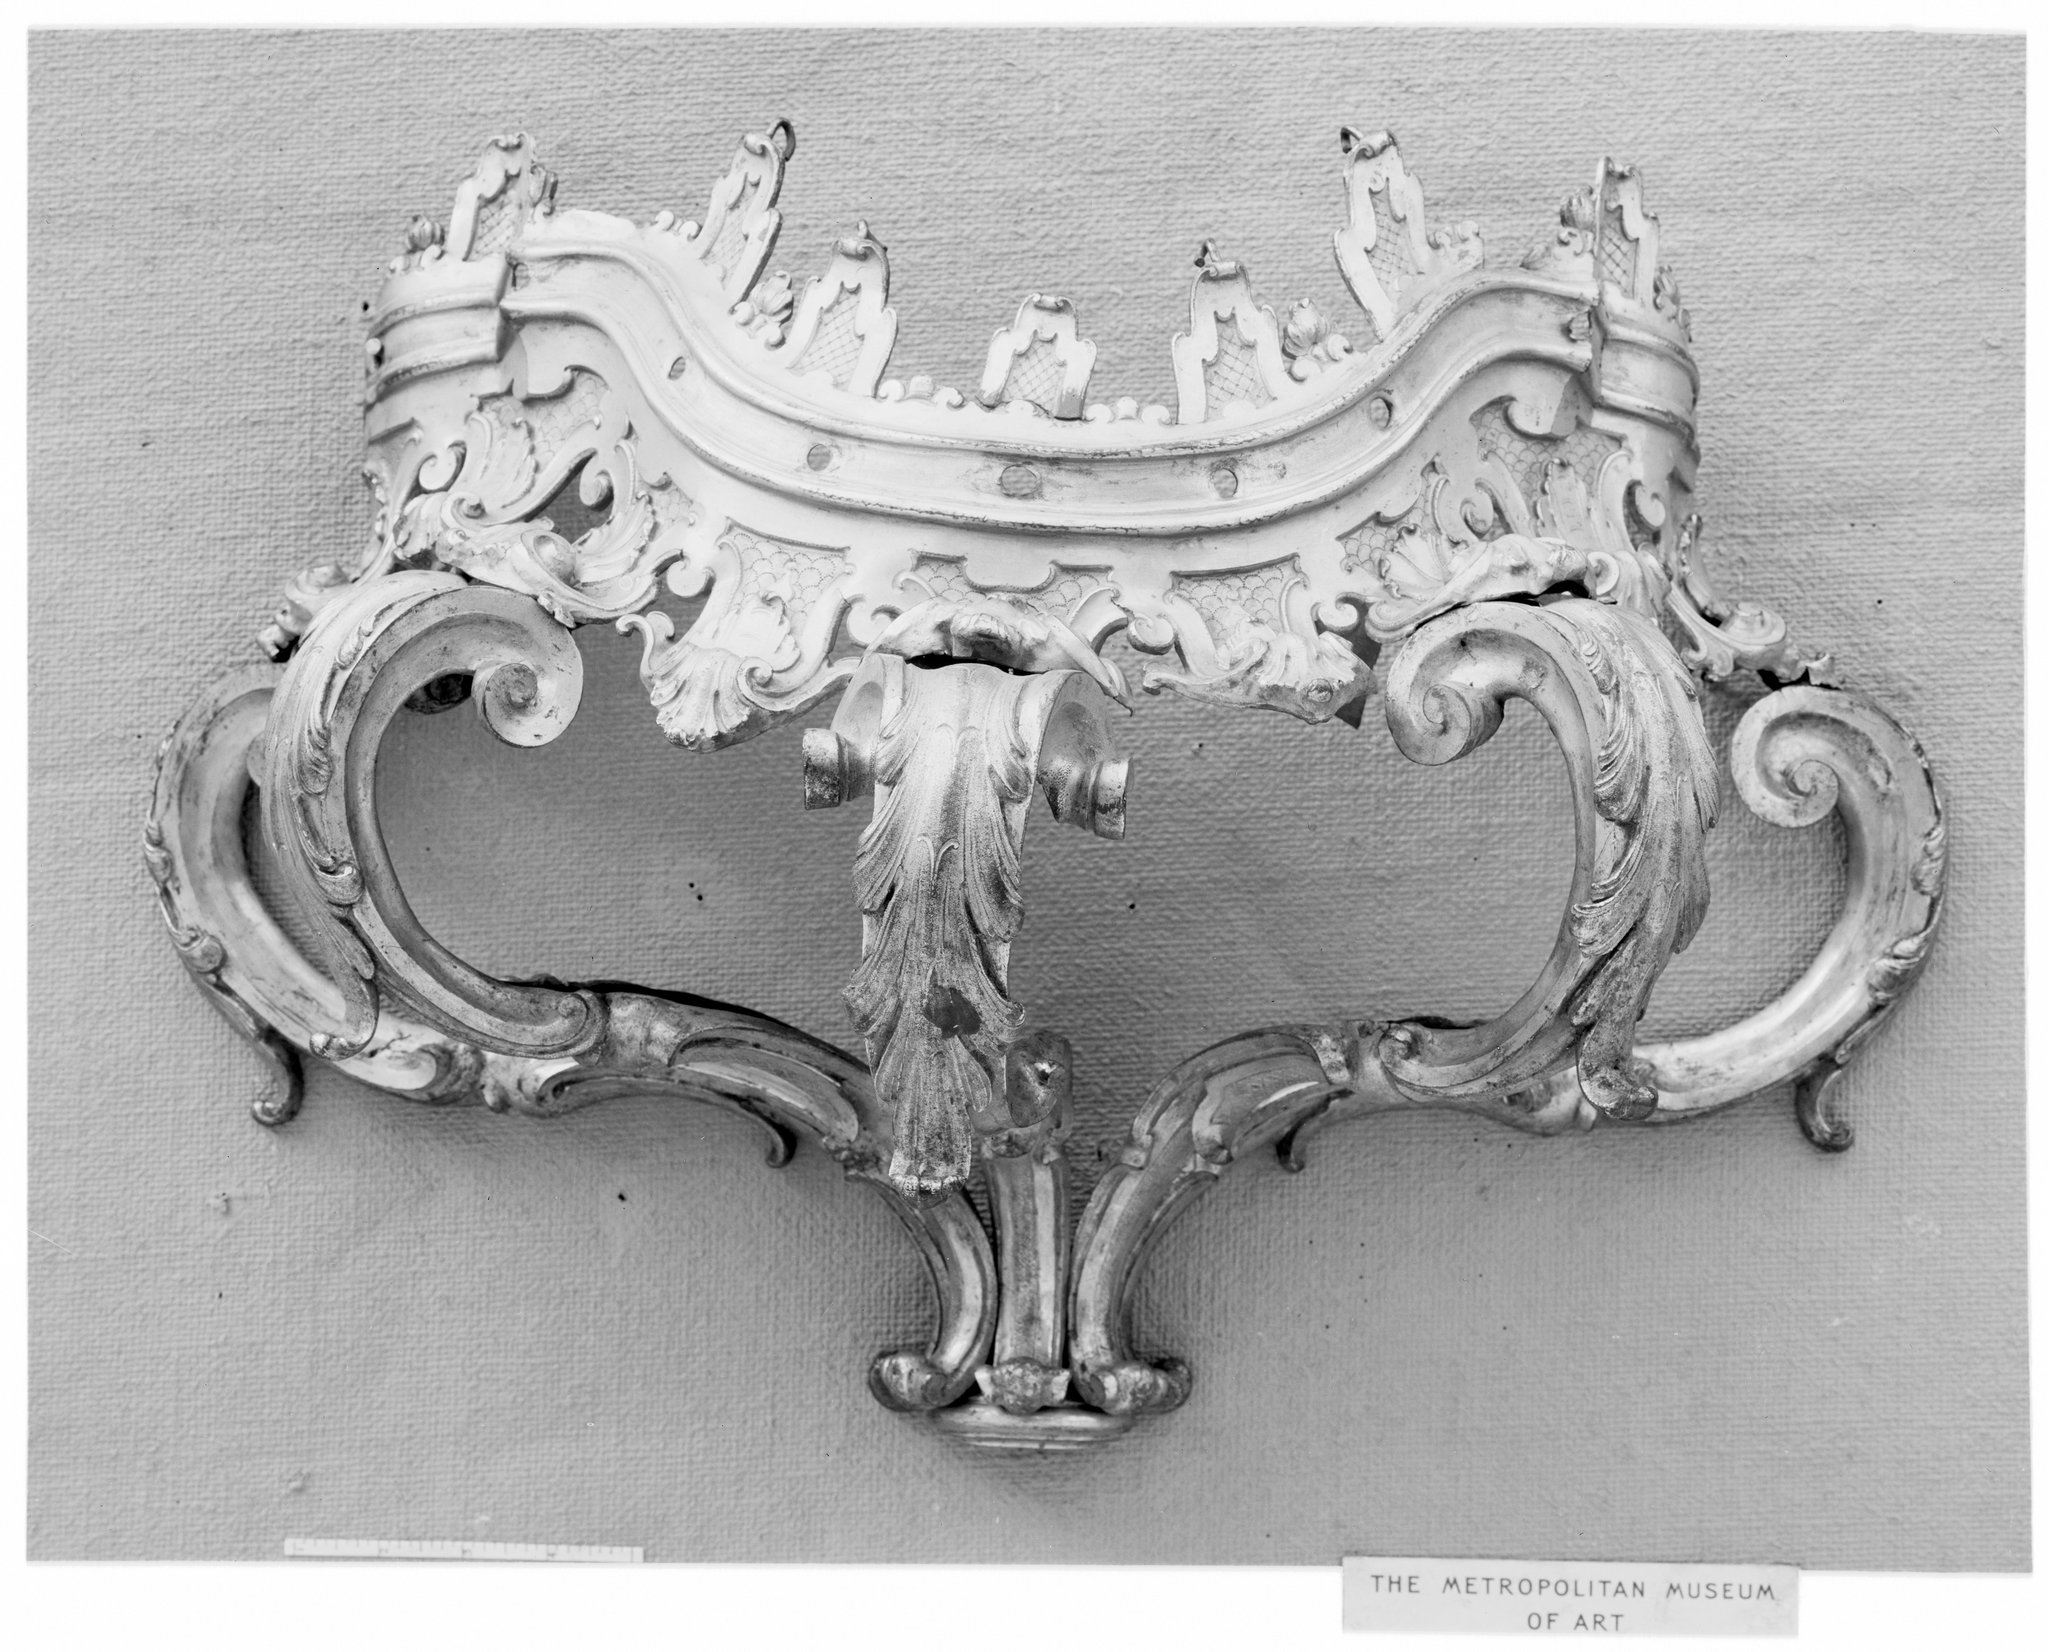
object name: crown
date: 1601-1800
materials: gilt bronze